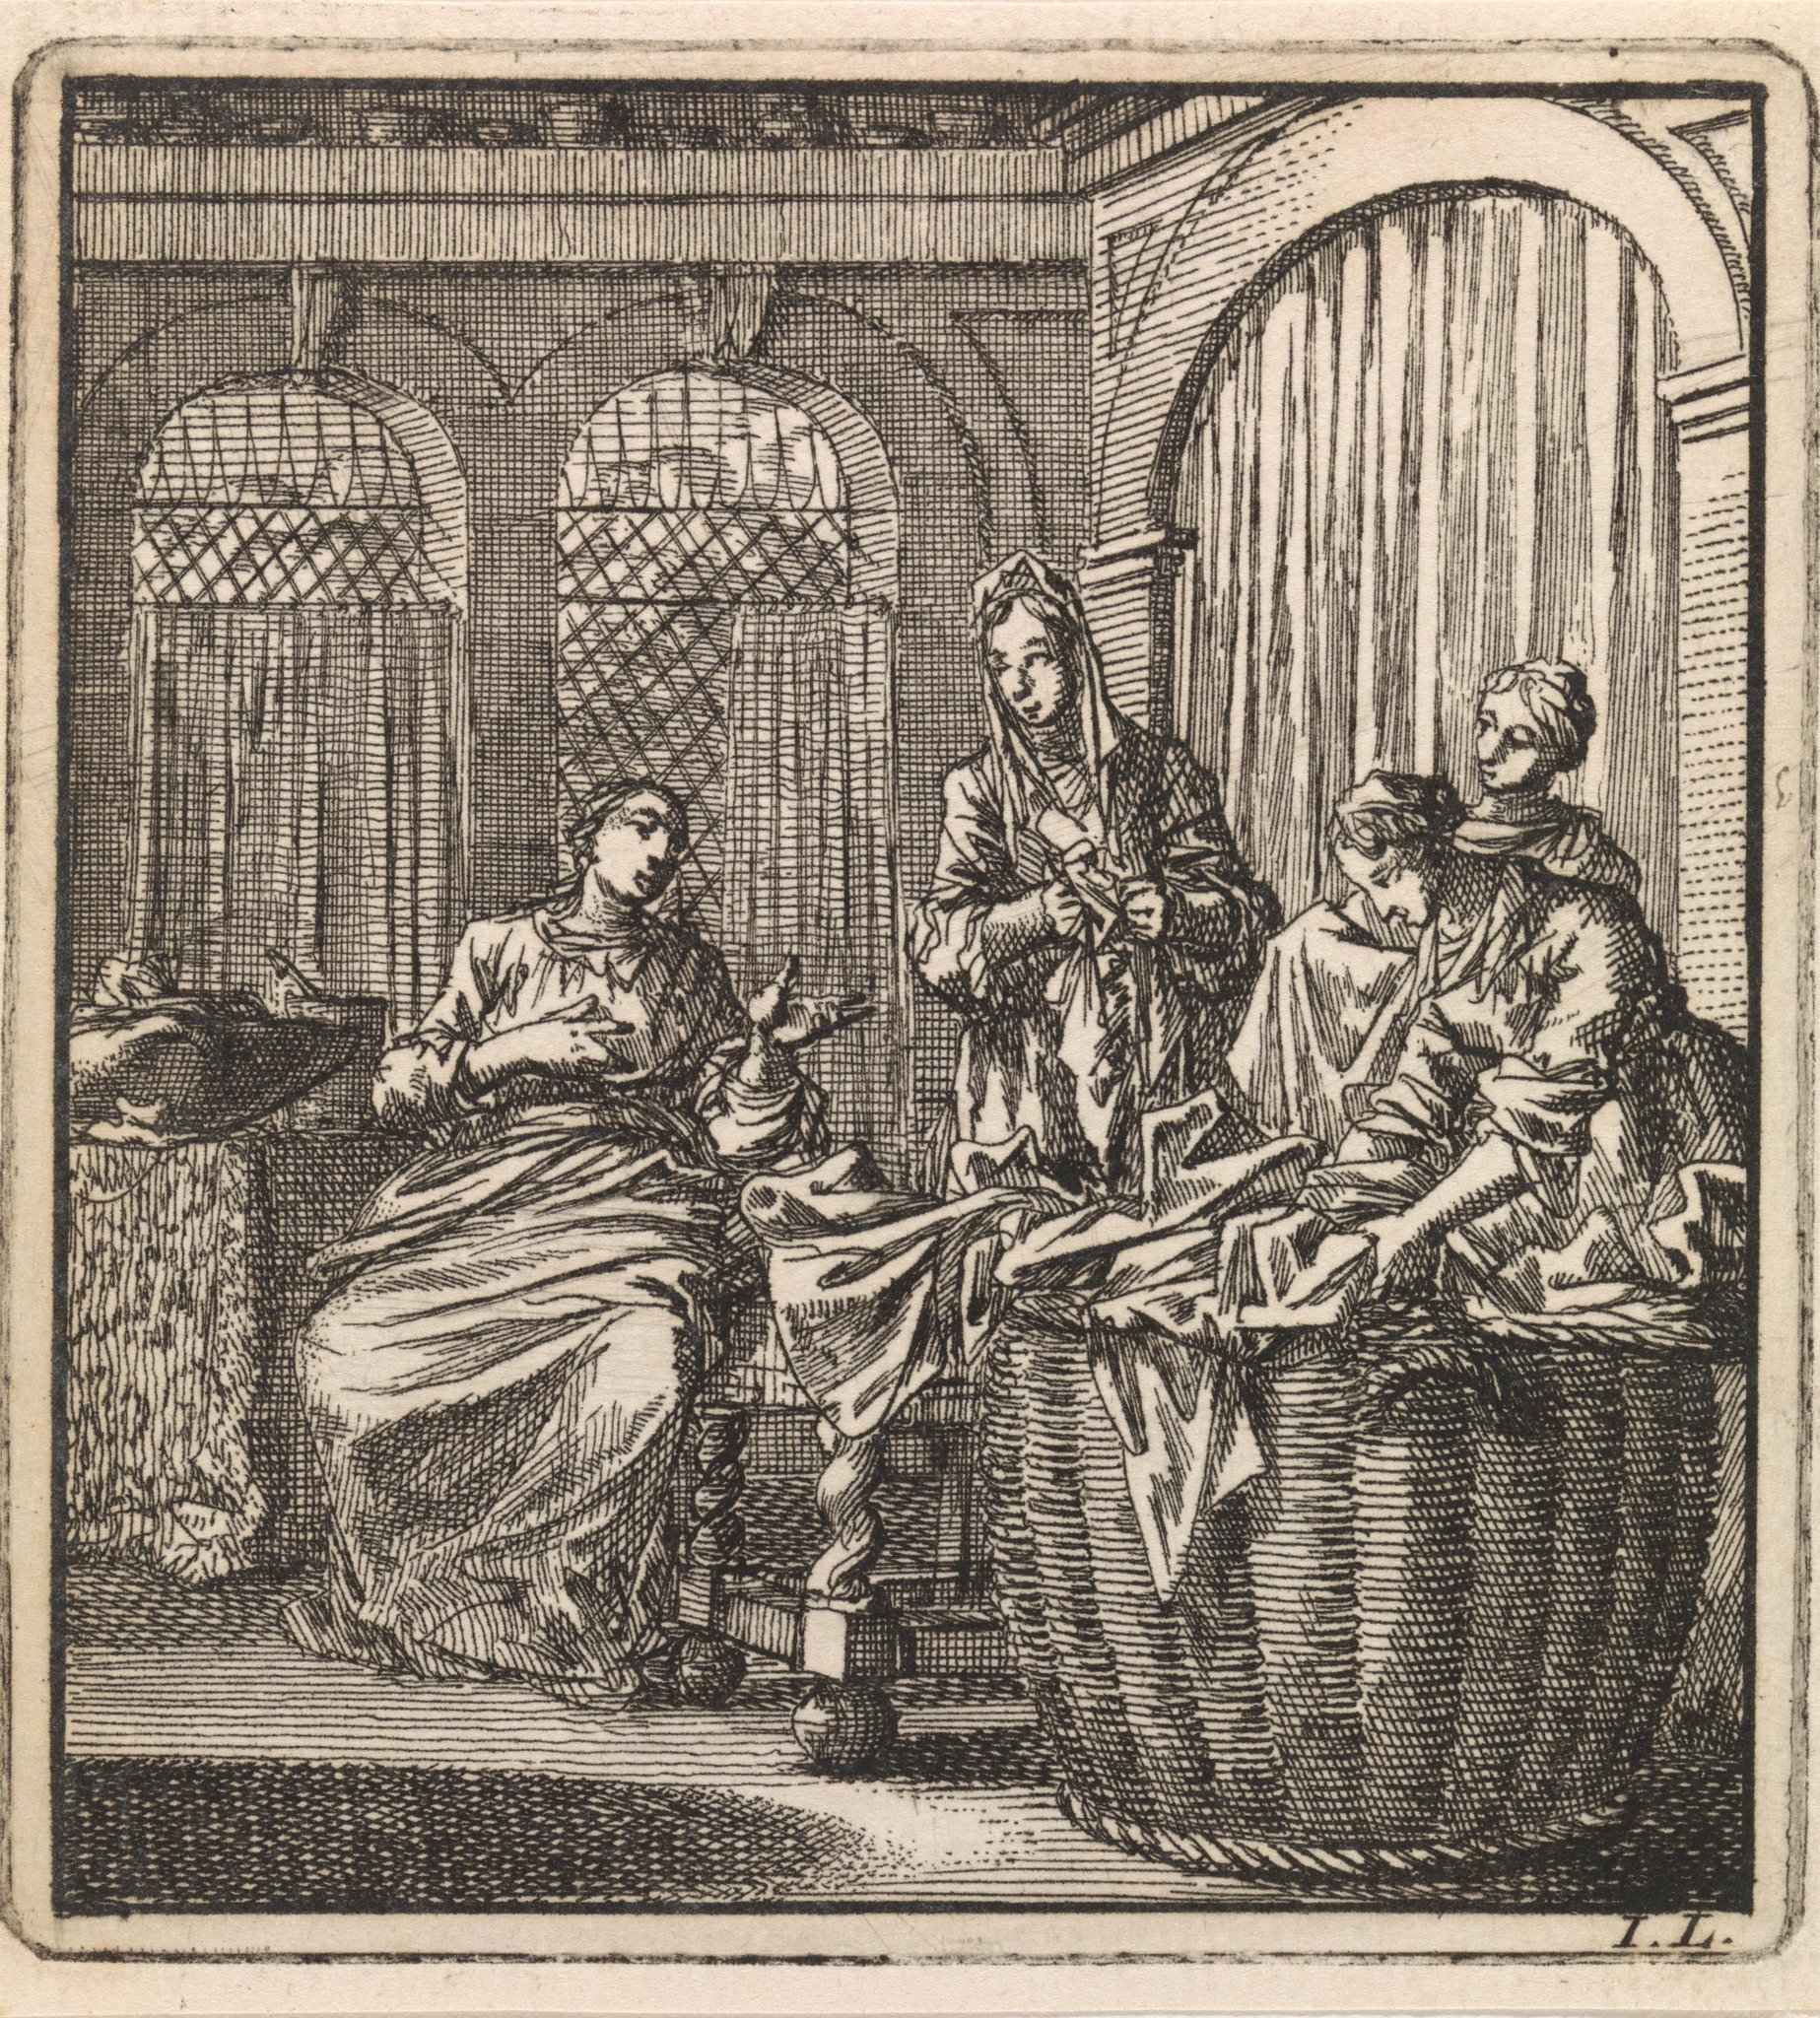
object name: print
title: De Kleerben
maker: jan luyken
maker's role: draughtsman, print maker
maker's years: 1649-1712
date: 1711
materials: paper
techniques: etching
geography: amsterdam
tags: container made of plant material other than wood: basket, wash house, home laundry, laundry room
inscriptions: collector's mark: Lugt 2228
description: Illustratie voor: Luyken, Jan. Het leerzaam huisraad, vertoond in vyftig konstige figuuren, met godlyke spreuken en stichtelyke verzen: Pieter Arentsz. II (wed.) en Cornelis van der Sys, 1711, p. 114.